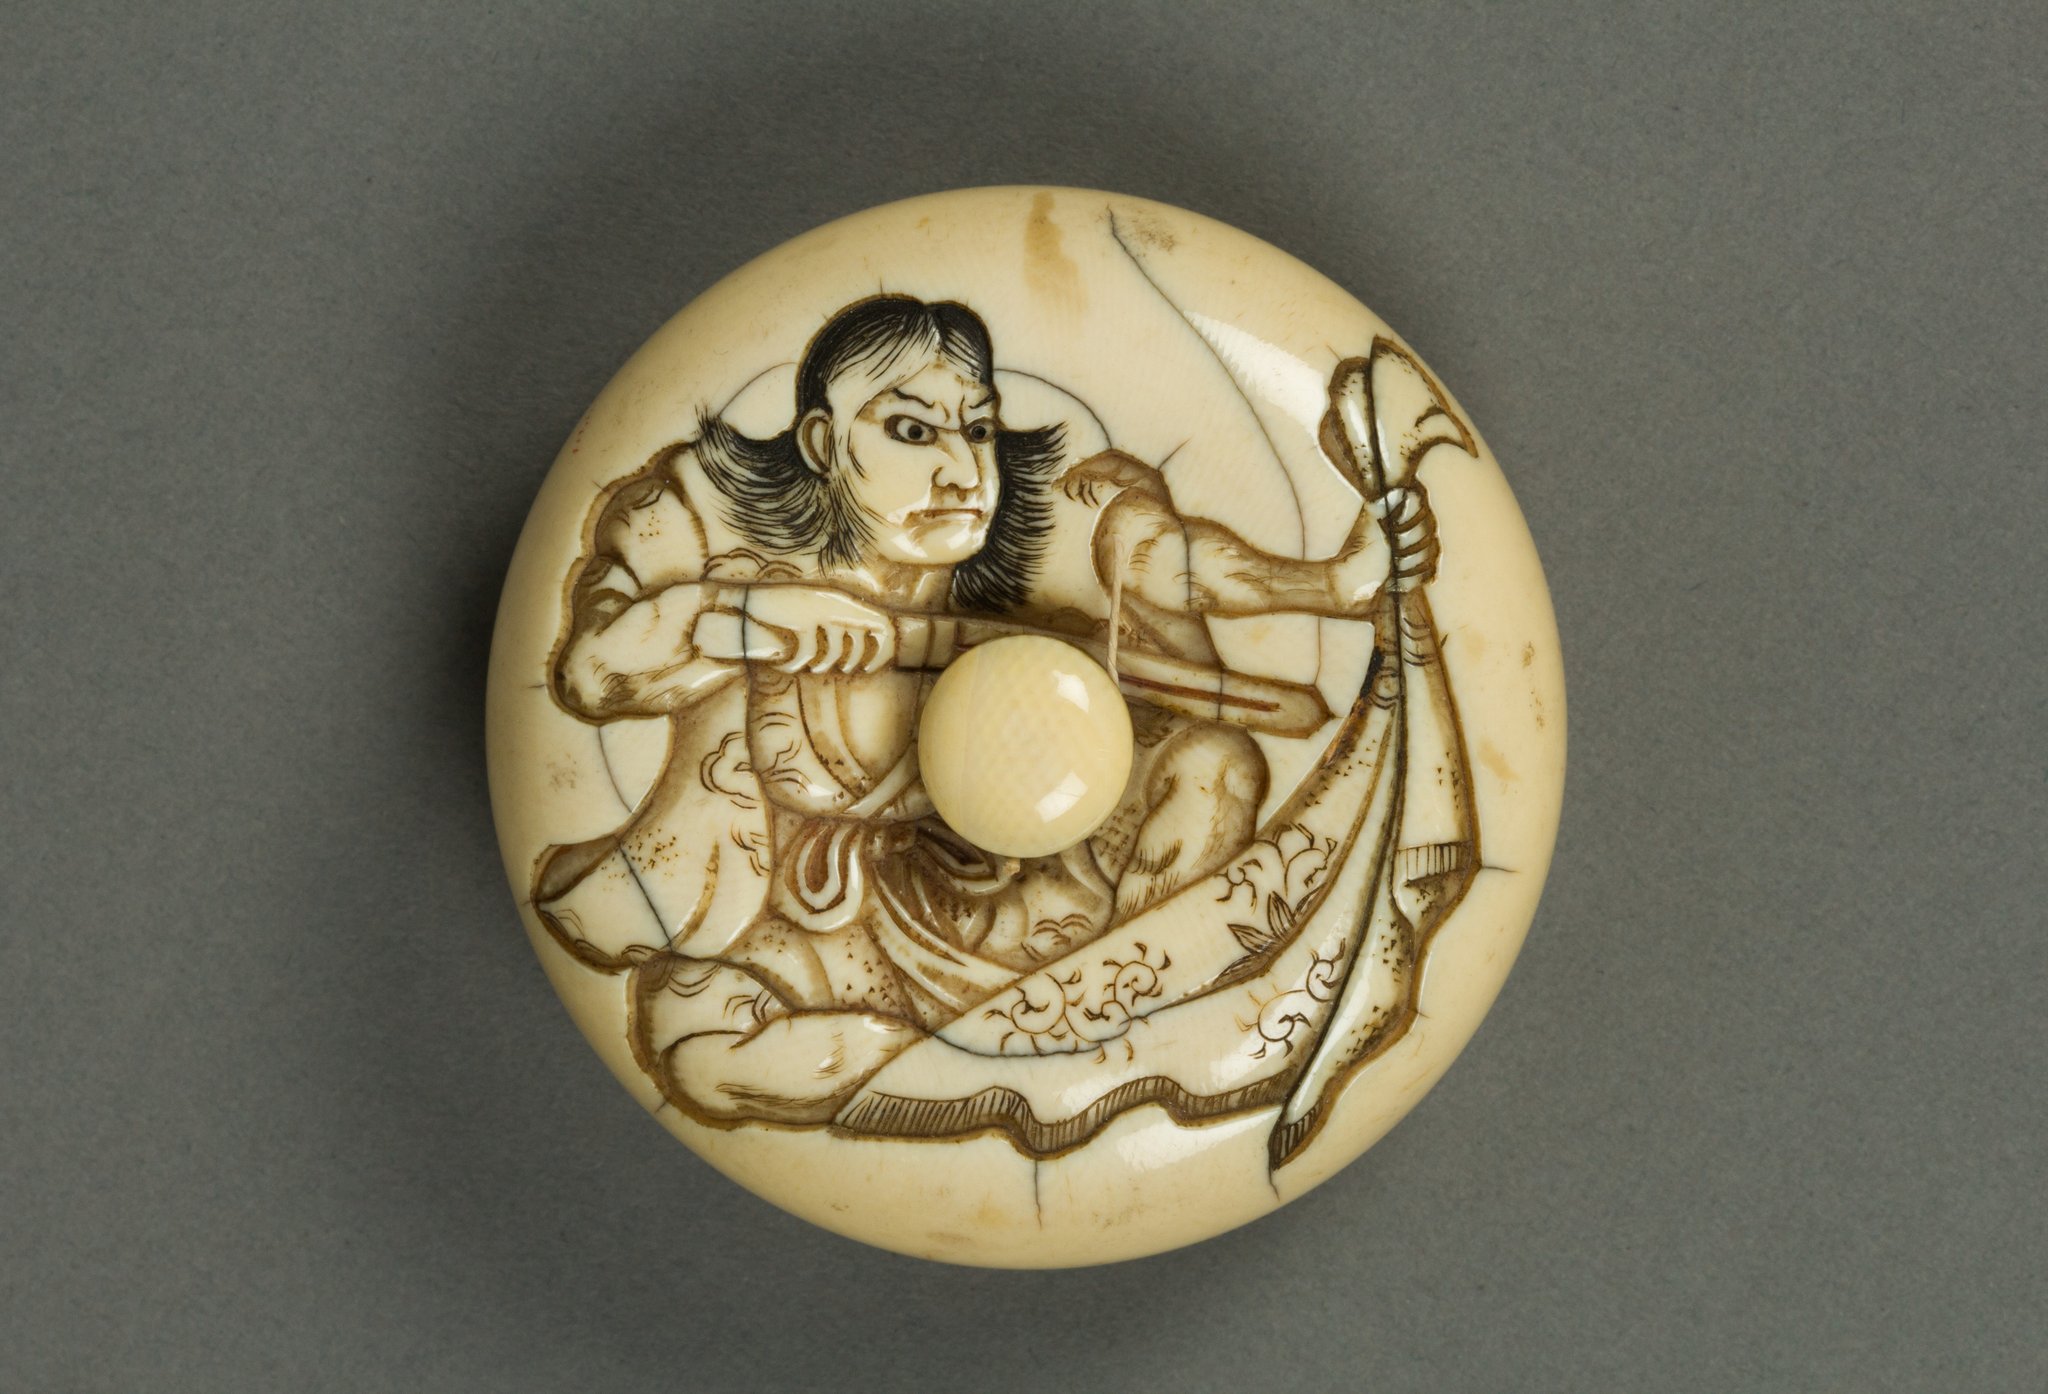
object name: netsuke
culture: japanese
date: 1801-1900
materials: ivory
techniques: carving, stain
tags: swords,men